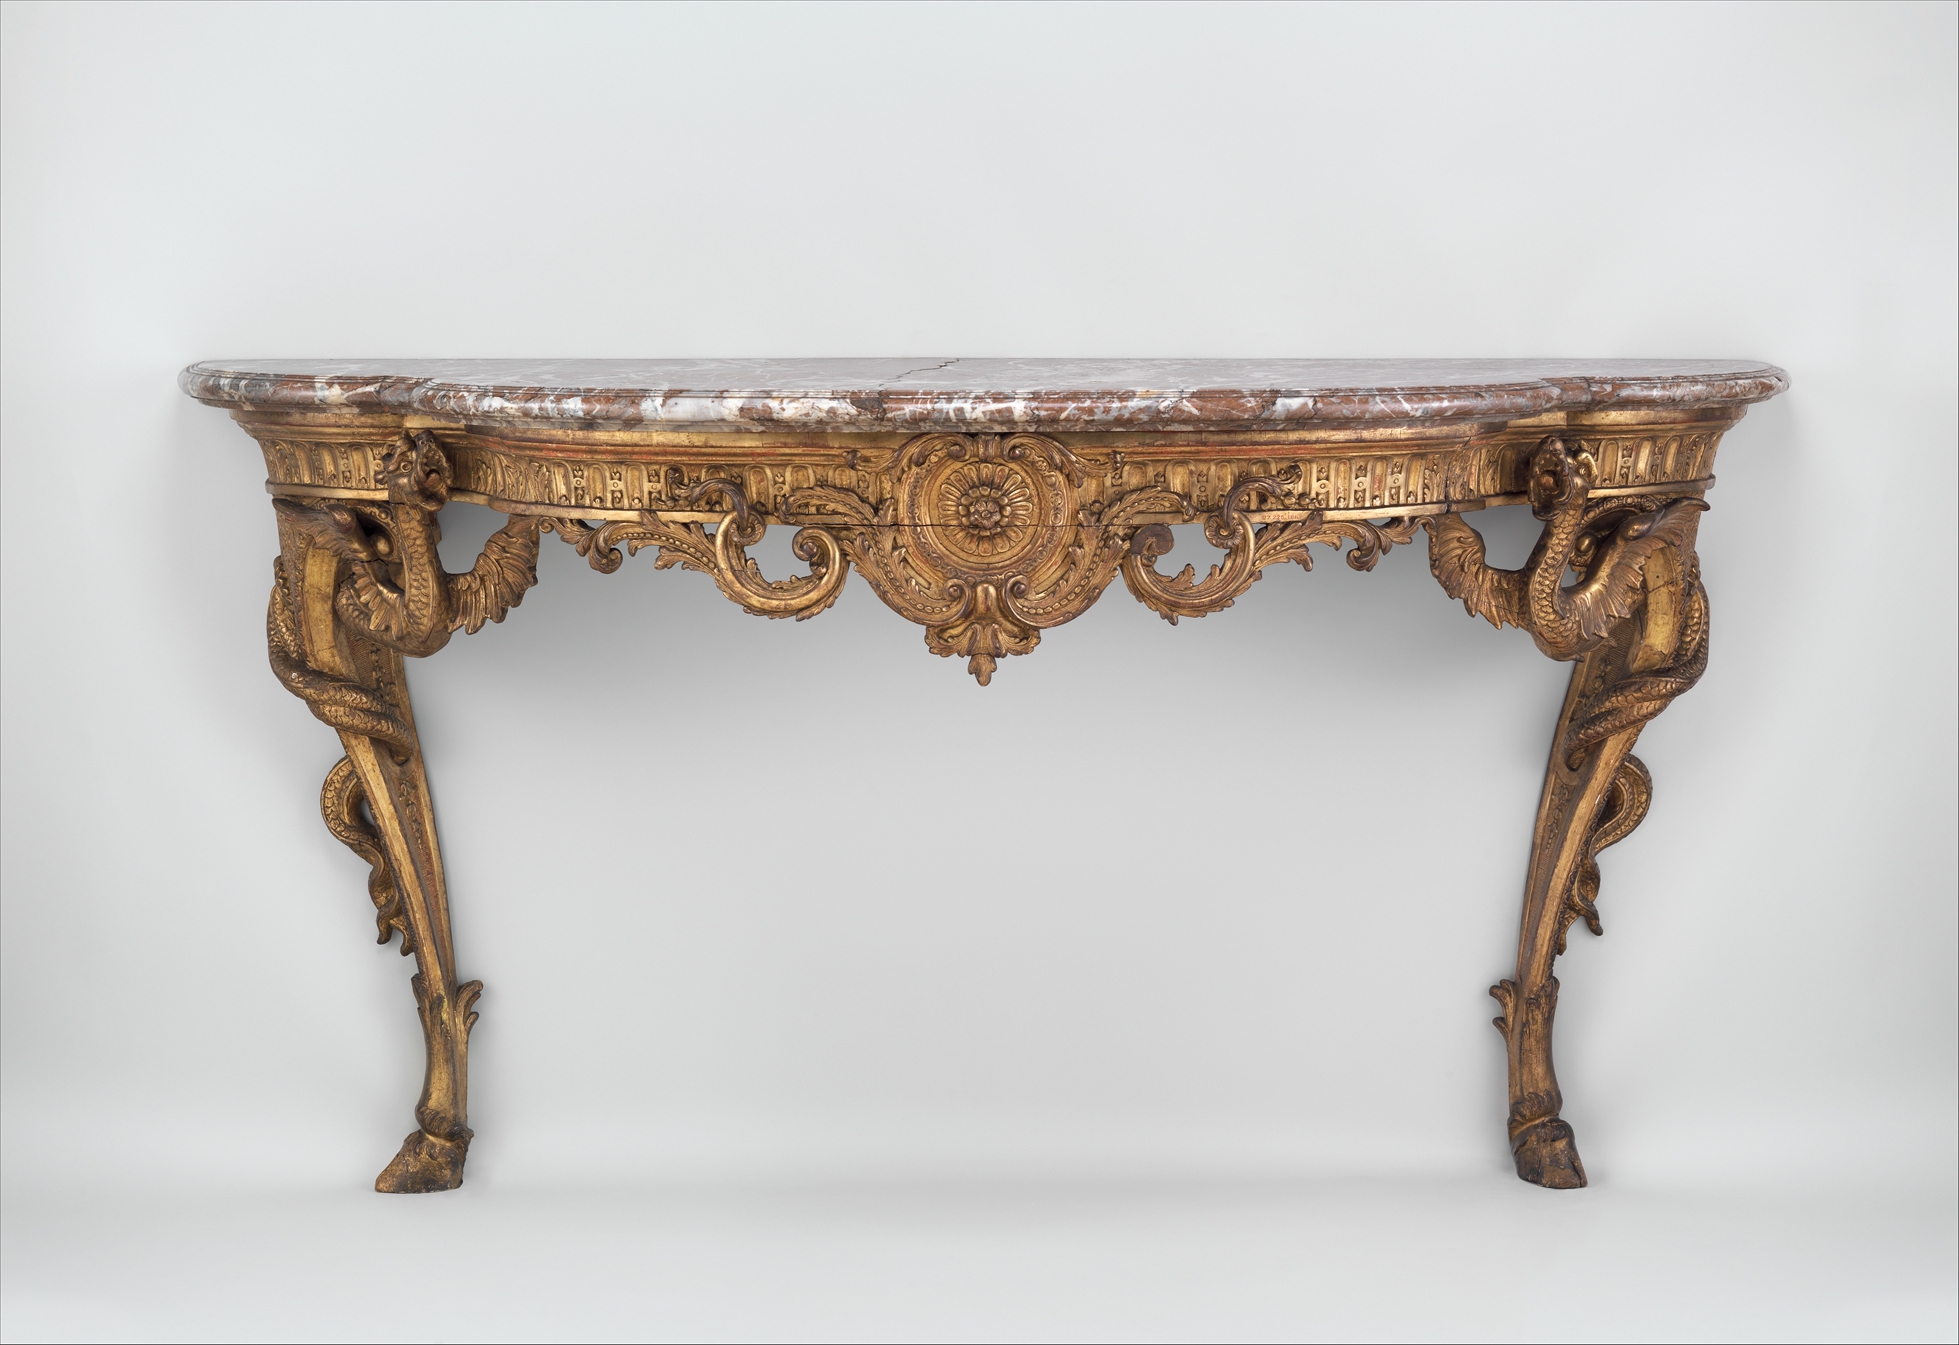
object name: console table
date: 1710-1720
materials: marble, wood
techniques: carving, gilding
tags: dragons